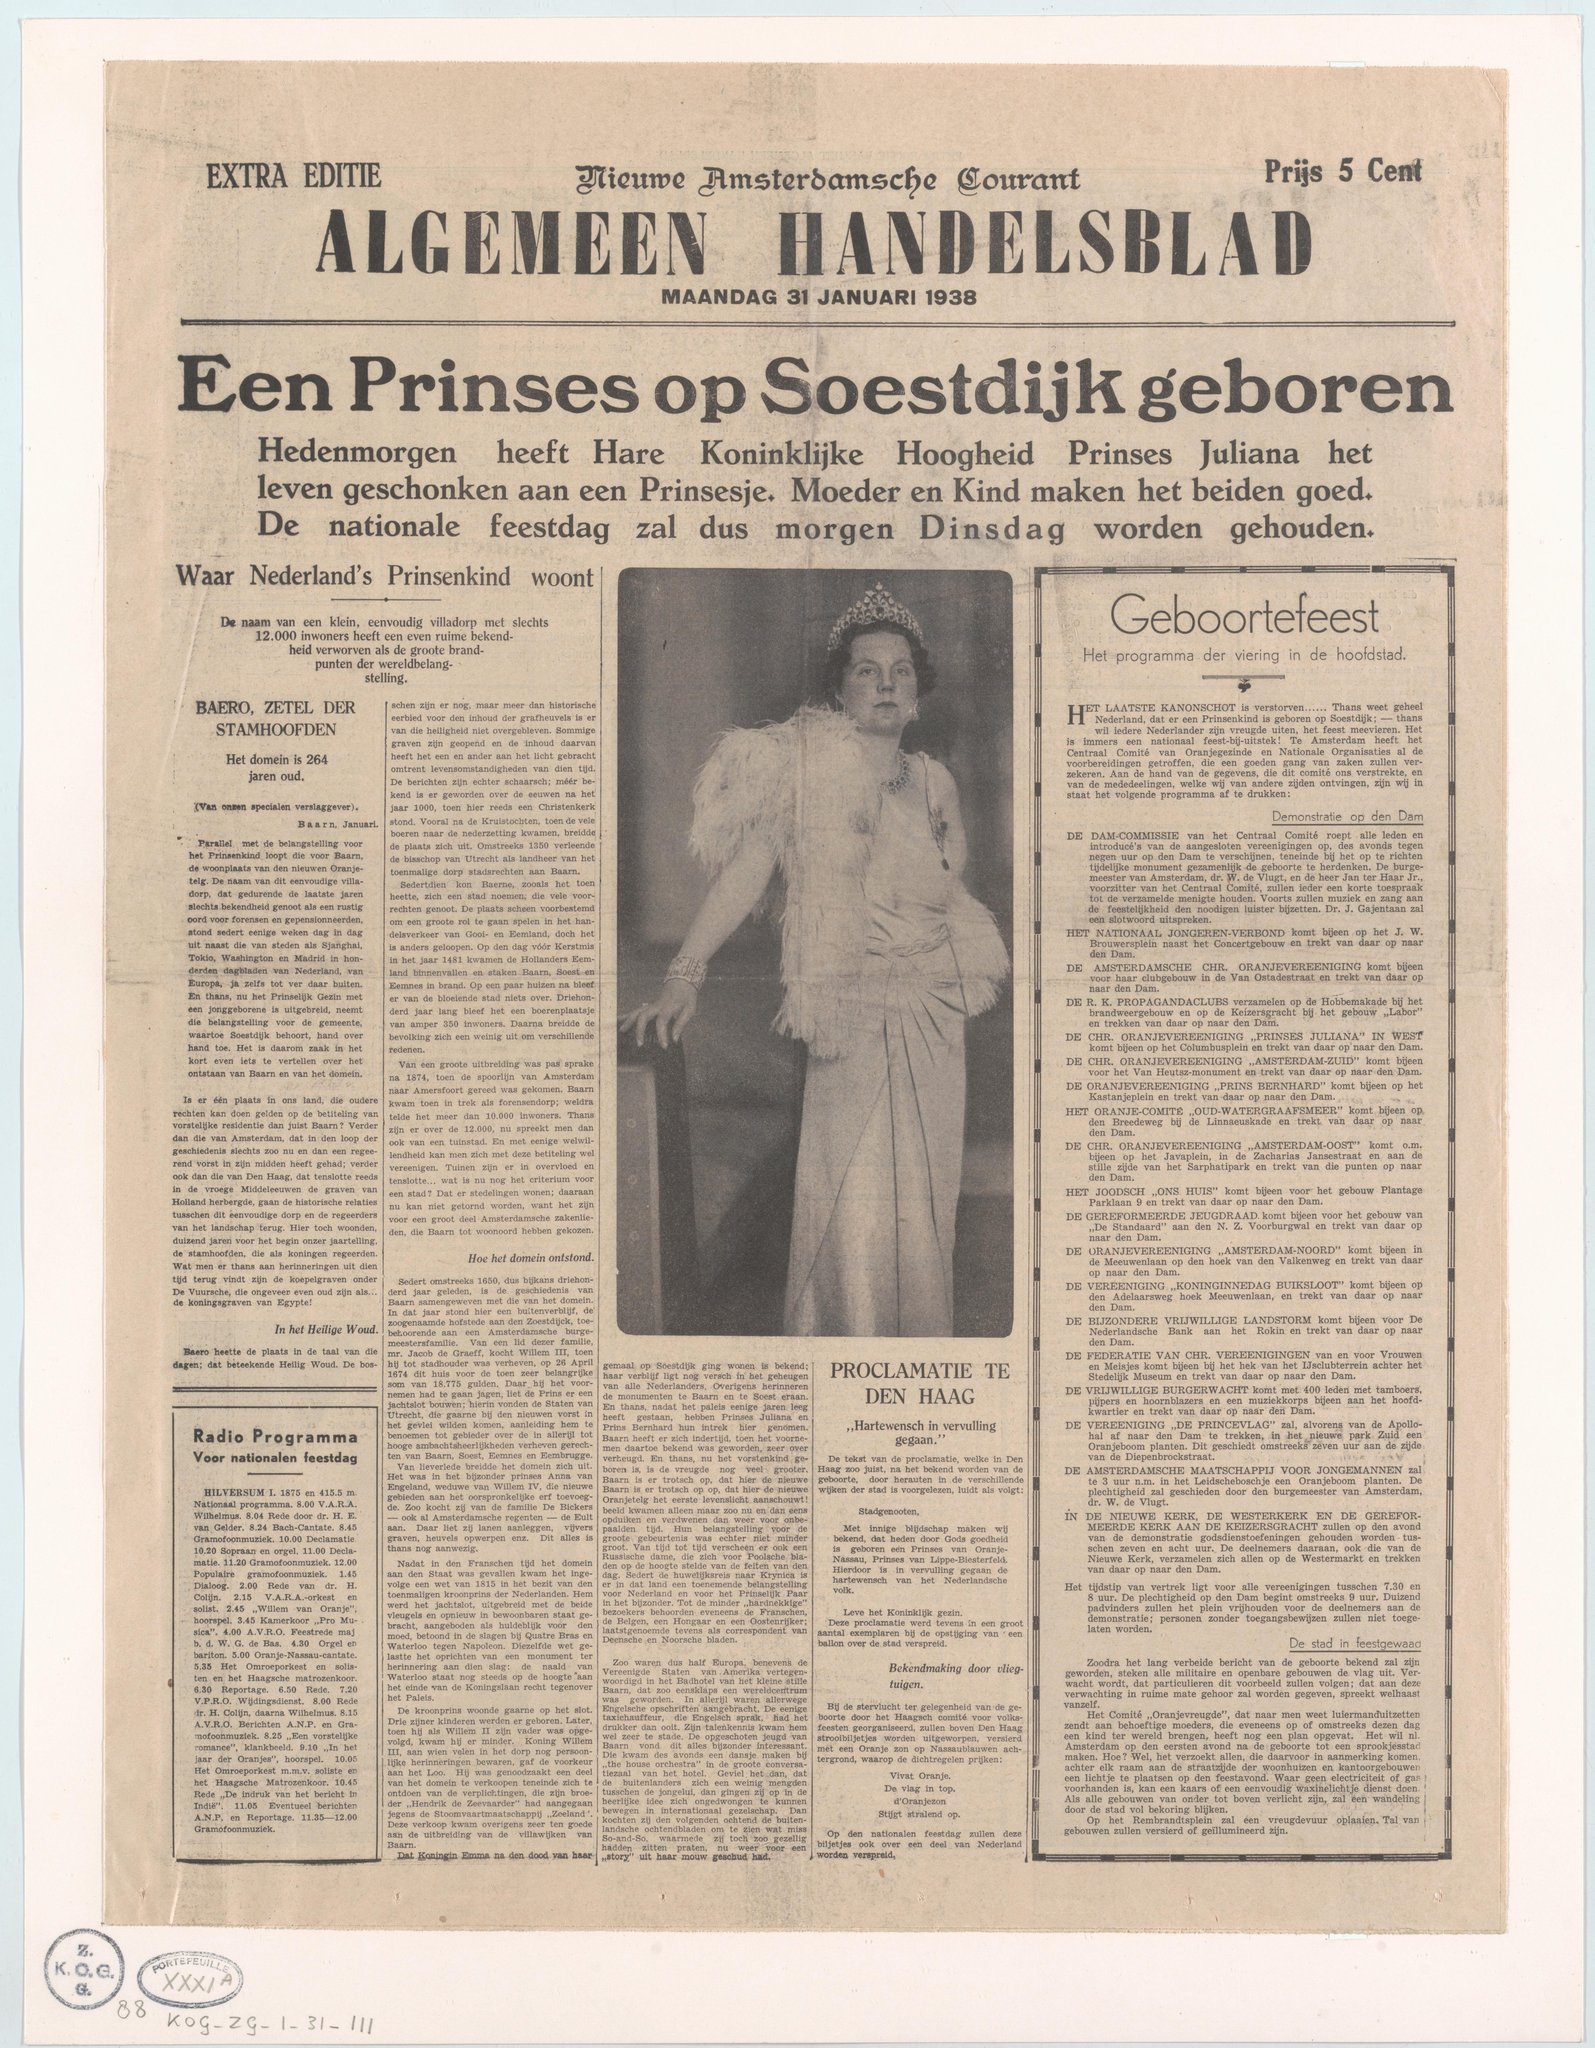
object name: photomechanical print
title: Portret van Juliana, koningin der Nederlanden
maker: Anonymous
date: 1938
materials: paper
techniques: letterpress printing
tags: beatrix (koningin der nederlanden), the hague, juliana of the netherlands, queen, empress, etc. (wife of a ruler), historical persons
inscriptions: collector's mark: Lugt 1641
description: Onderwerpsrubrieken binnen de Atlas Zeden en Gewoonten: Portretten, Portretten van Vorsten uit het huis van Oranje, Regeerende Vorsten, Koningen uit het huis van Oranje.